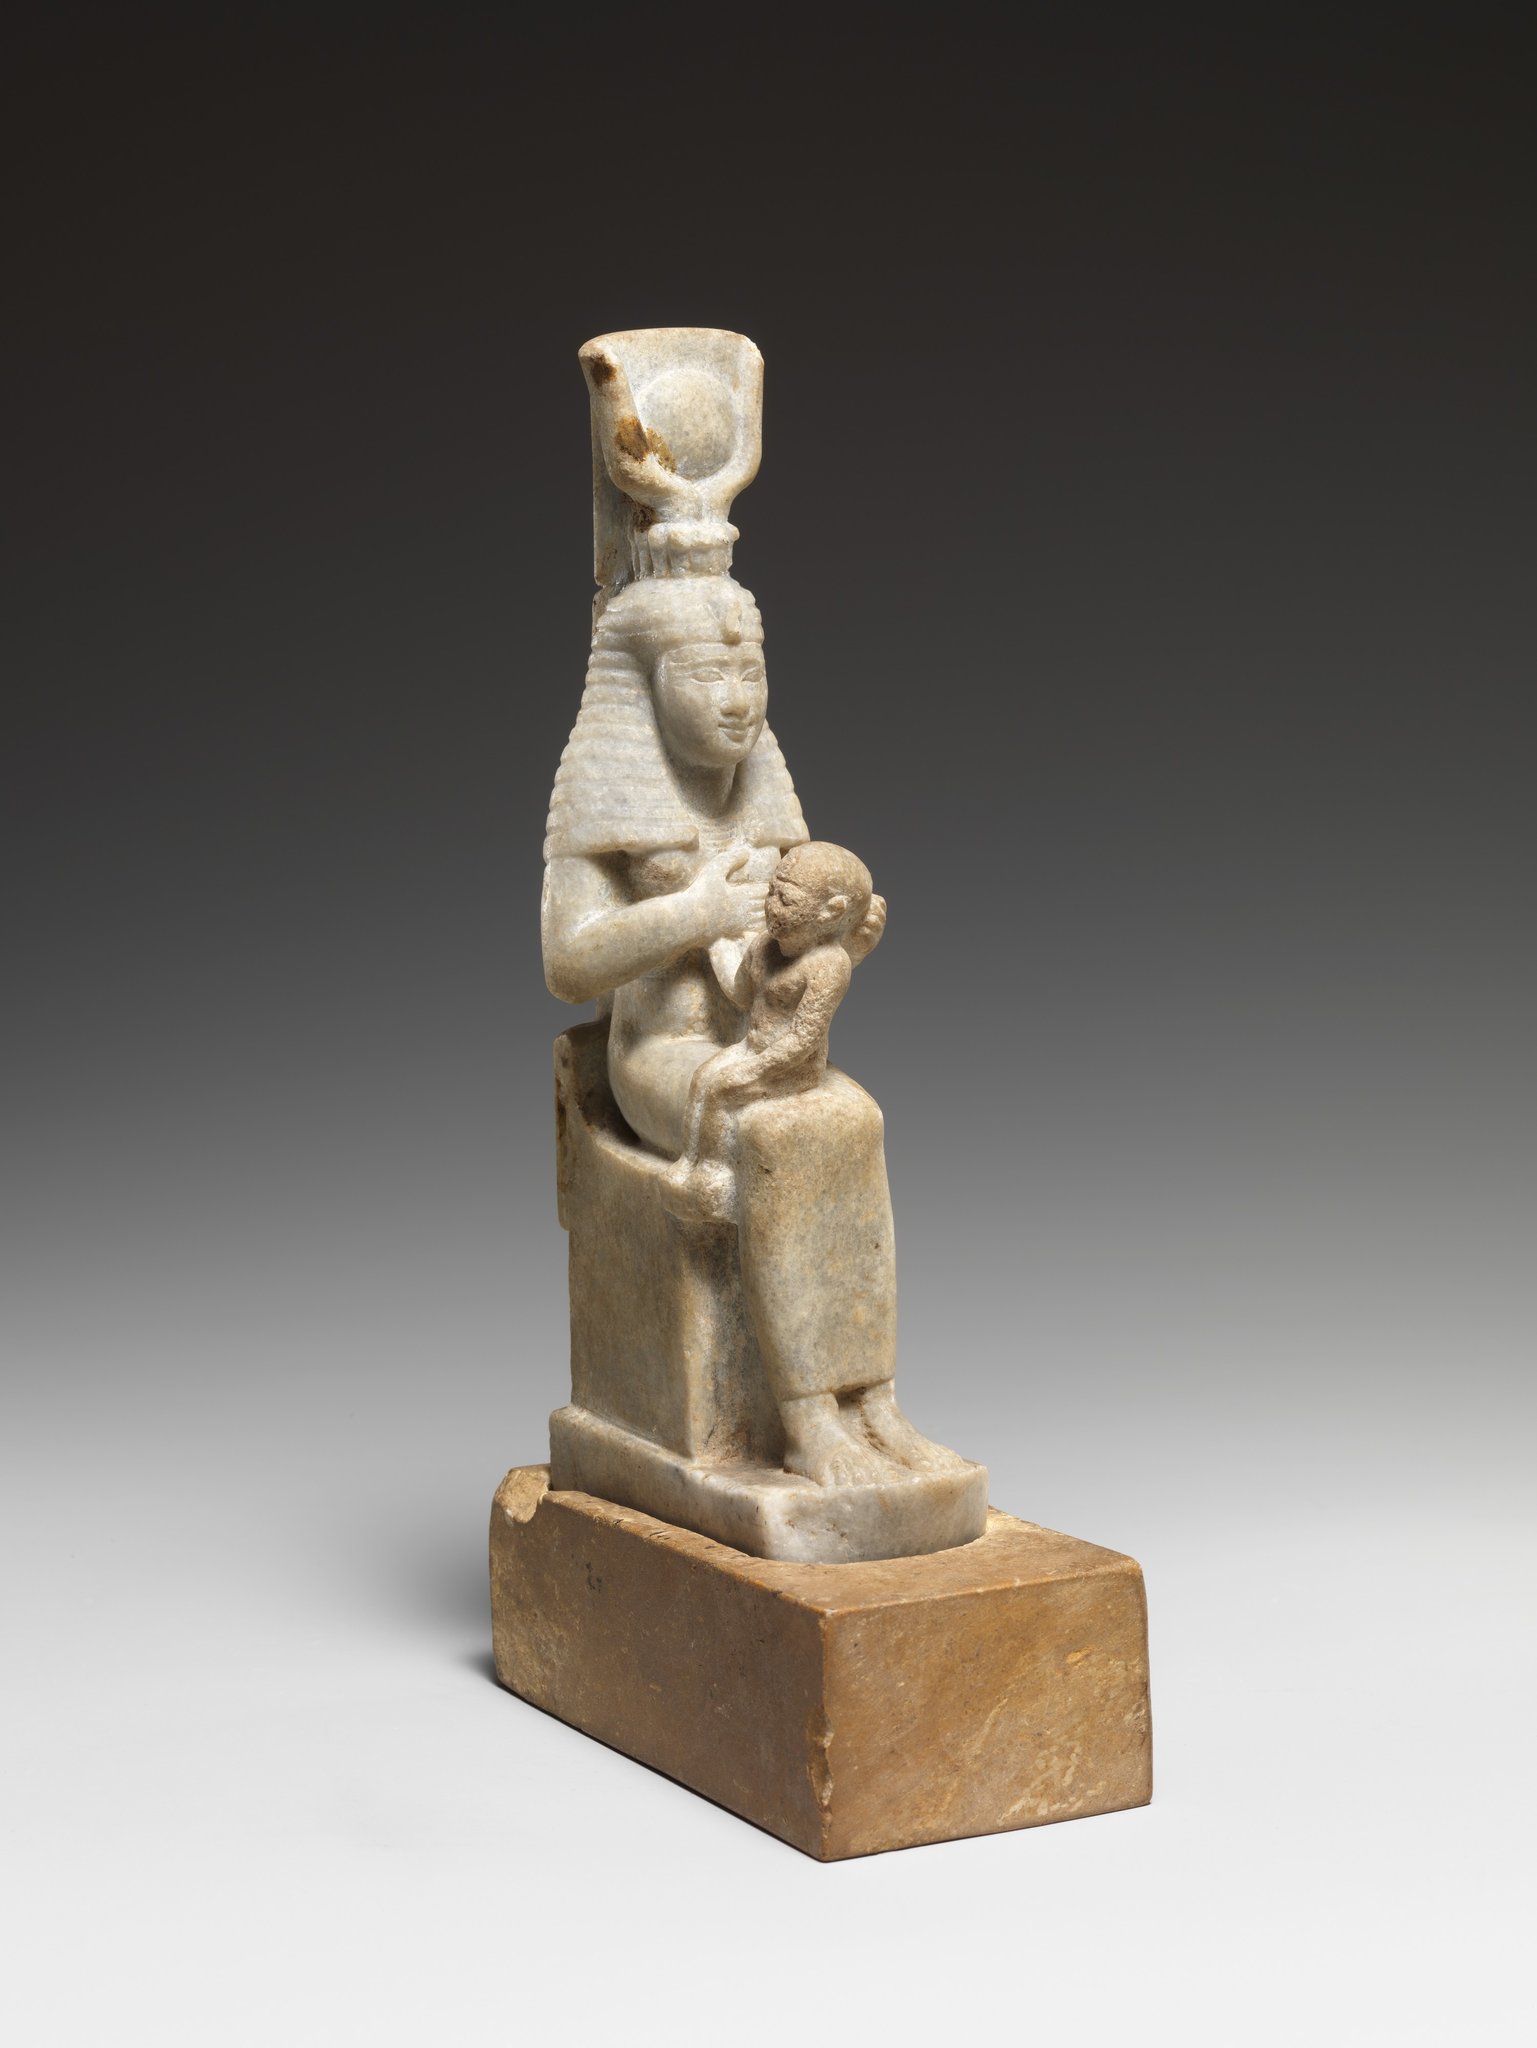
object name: statuette, isi, horus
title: Isis with Horus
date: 332-330 BCE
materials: limestone, marble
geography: egypt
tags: horus,isis